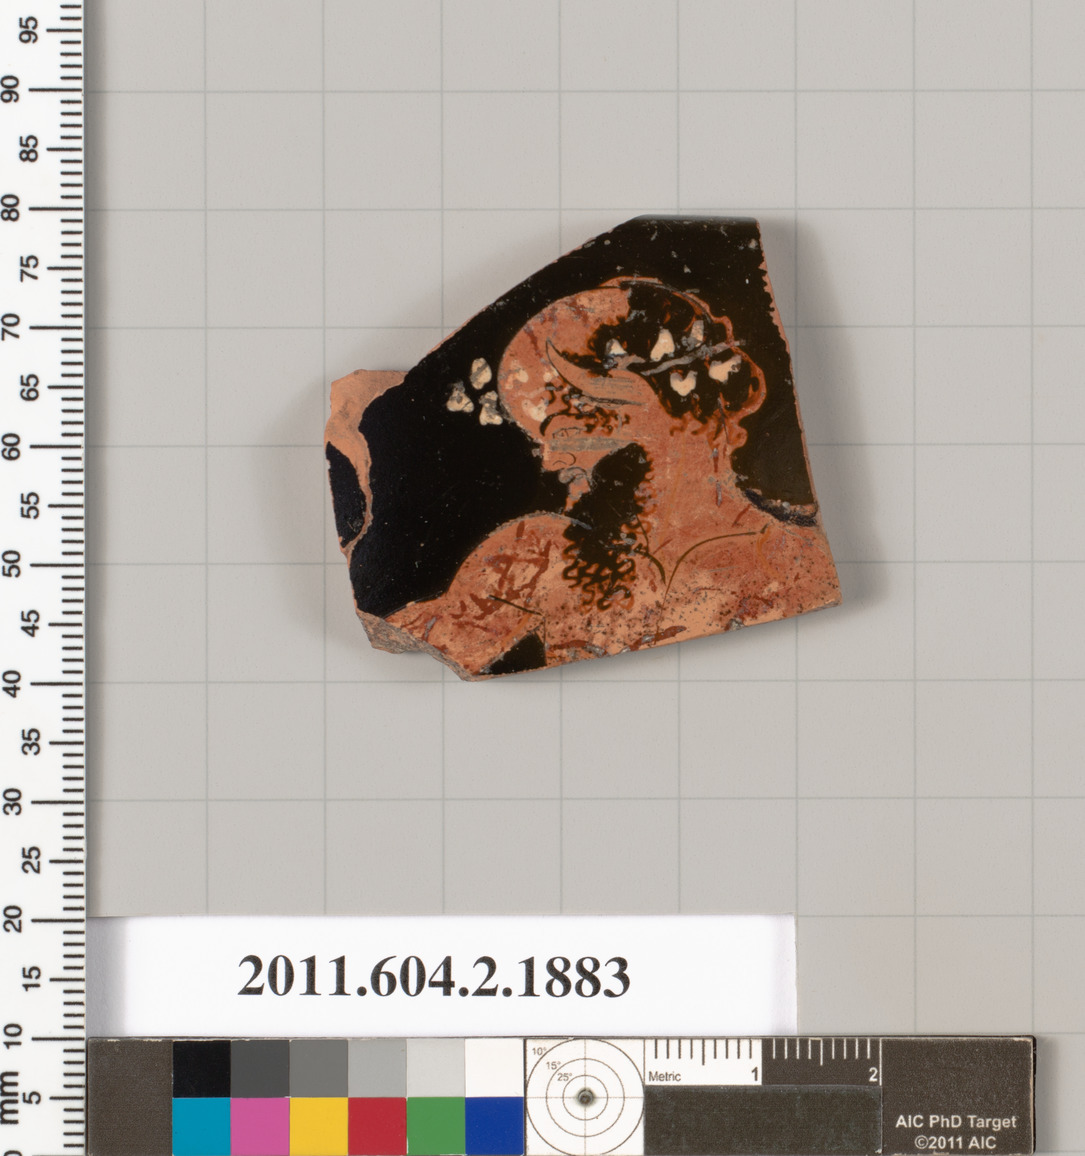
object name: skyphos fragment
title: Terracotta rim fragment of a skyphos (deep drinking cup)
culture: greek, attic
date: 440-420 BCE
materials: terracotta